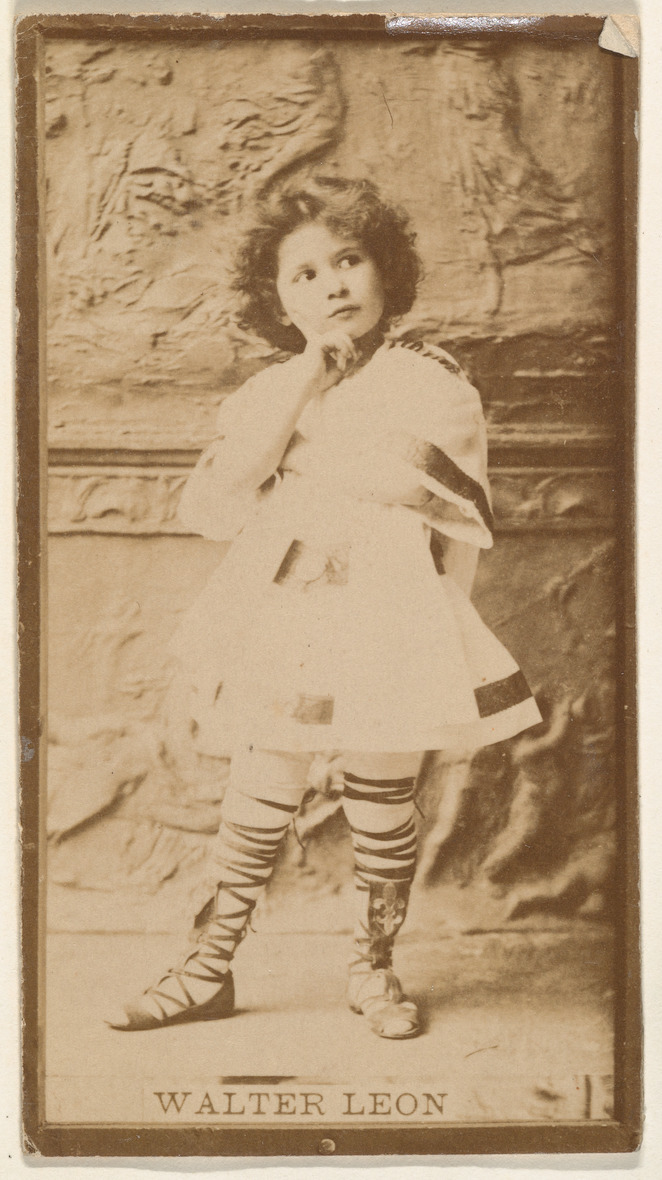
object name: photograph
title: Walter Leon, from the Actresses series (N668)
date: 1888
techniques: albumen silver print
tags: girls,portraits,actresses